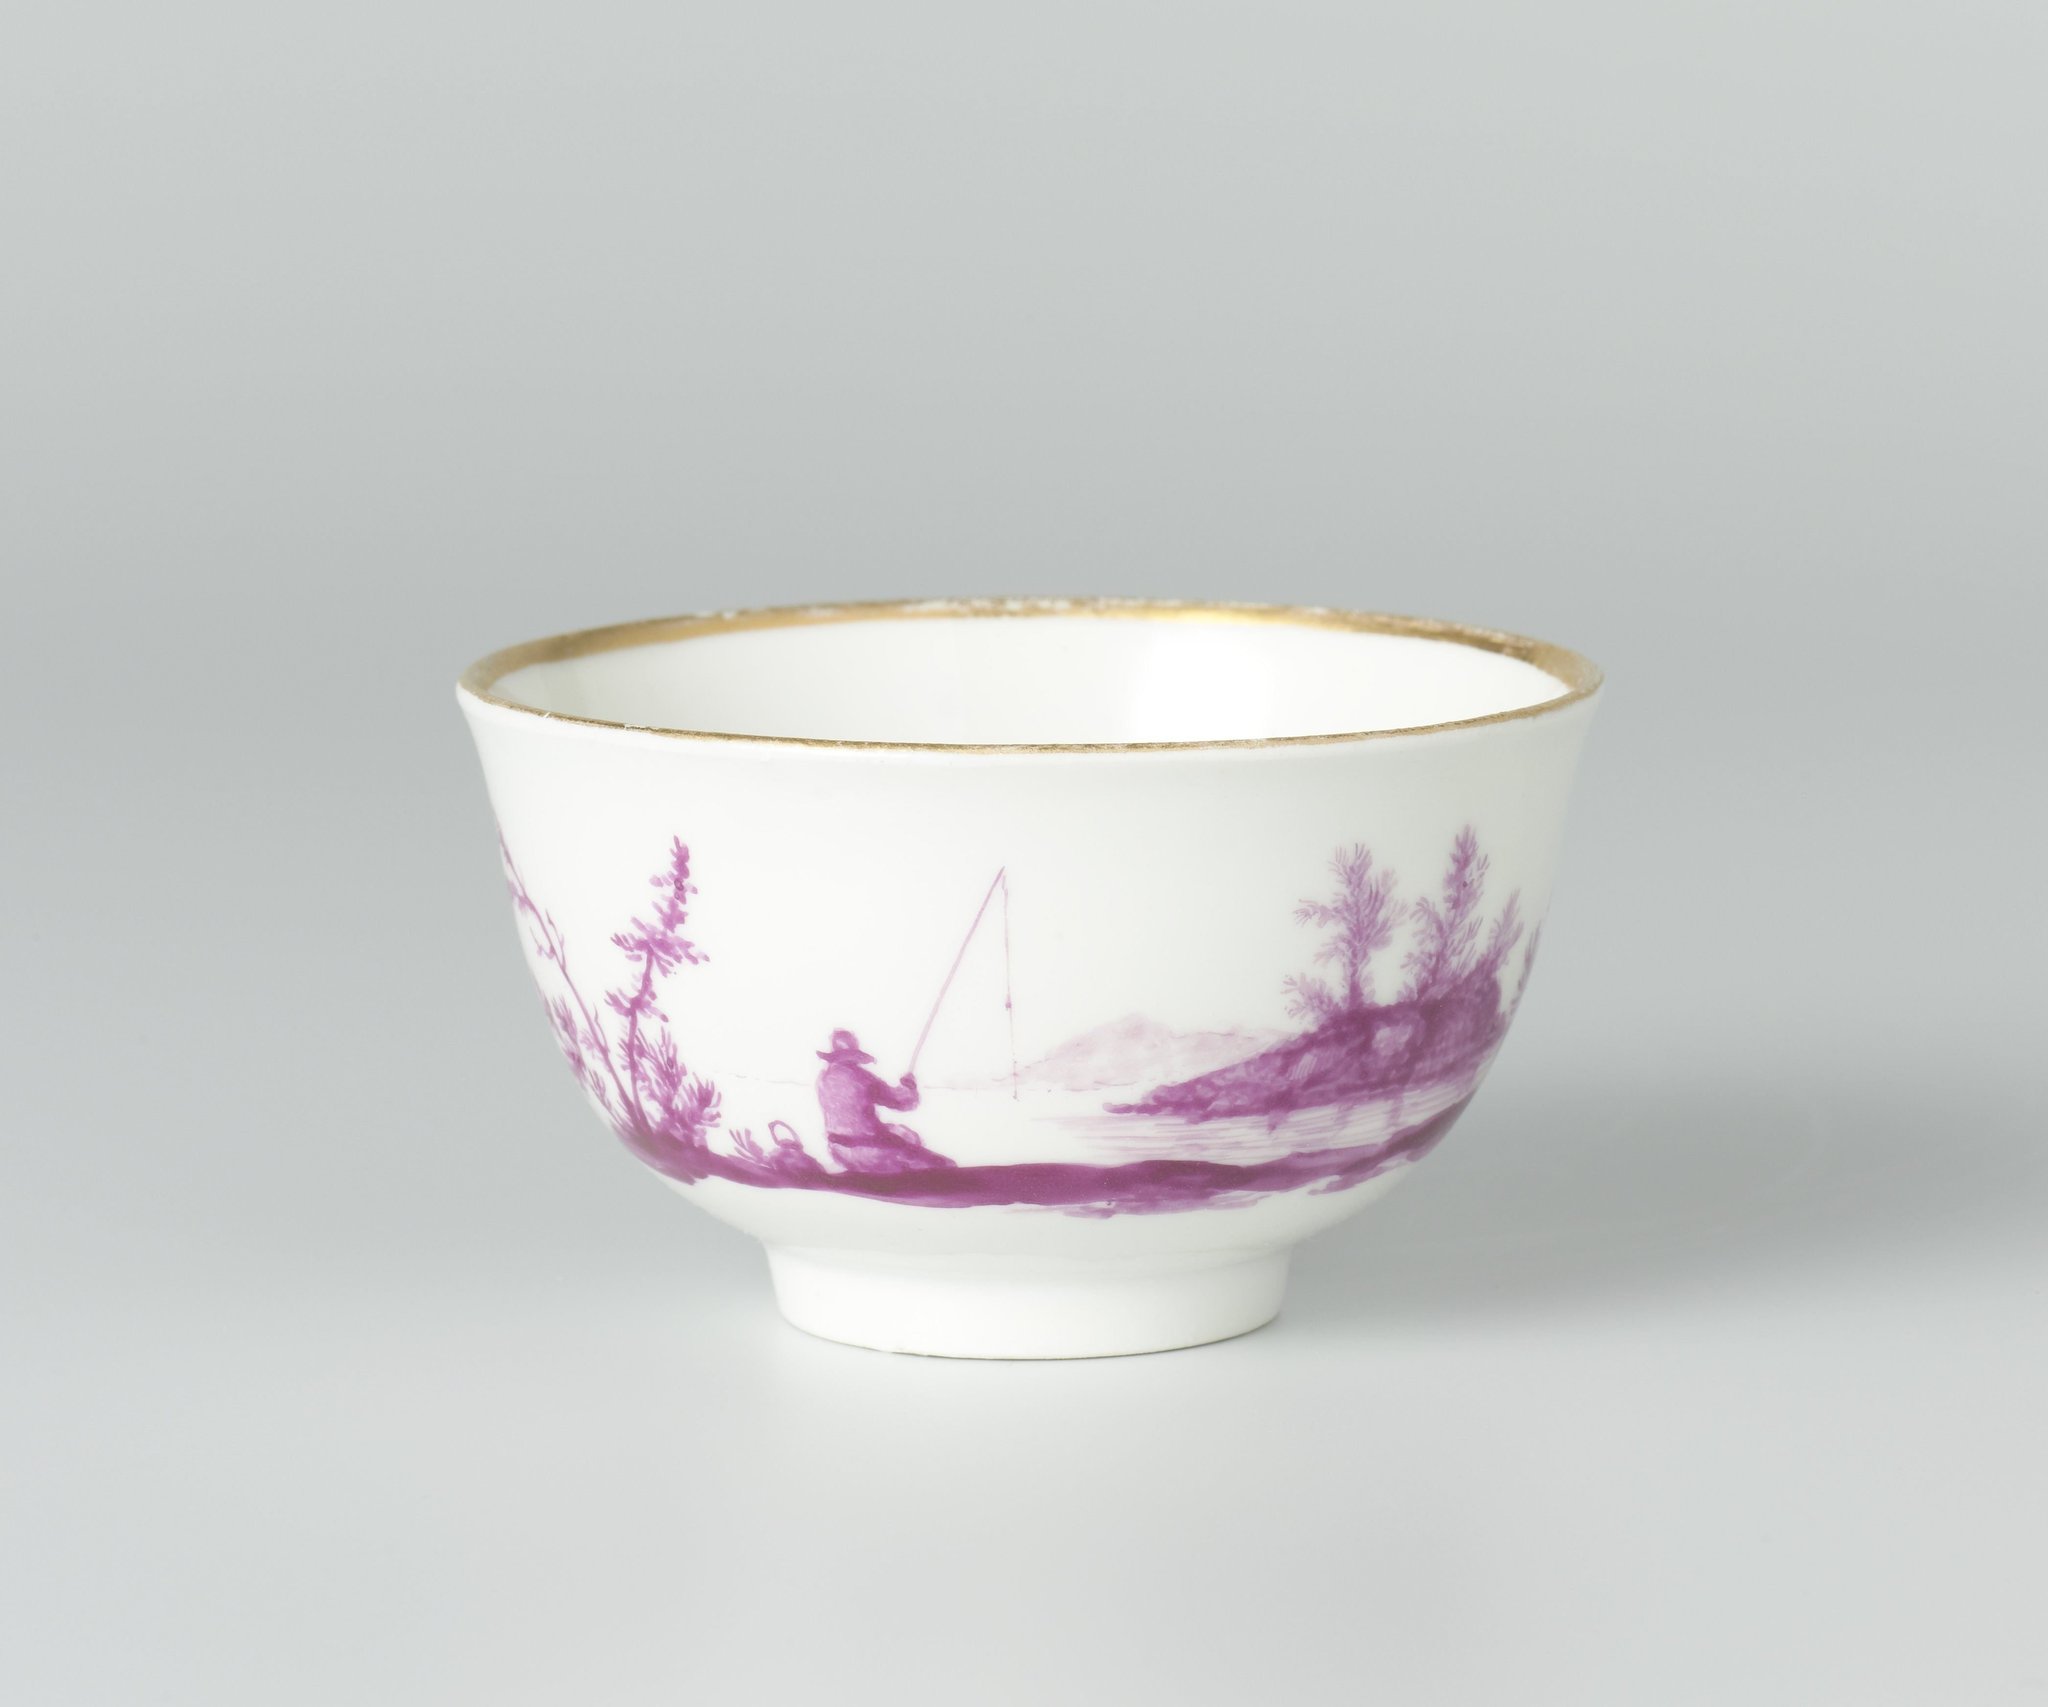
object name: cup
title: Theekop met figuren in landschap in bietenrood met gouden biezen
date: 1775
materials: porcelain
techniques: painted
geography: loosdrecht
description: Theekop van porselein, zonder oor. Beschilderd met figuren in een landschap in bietenrood en gouden biezen.